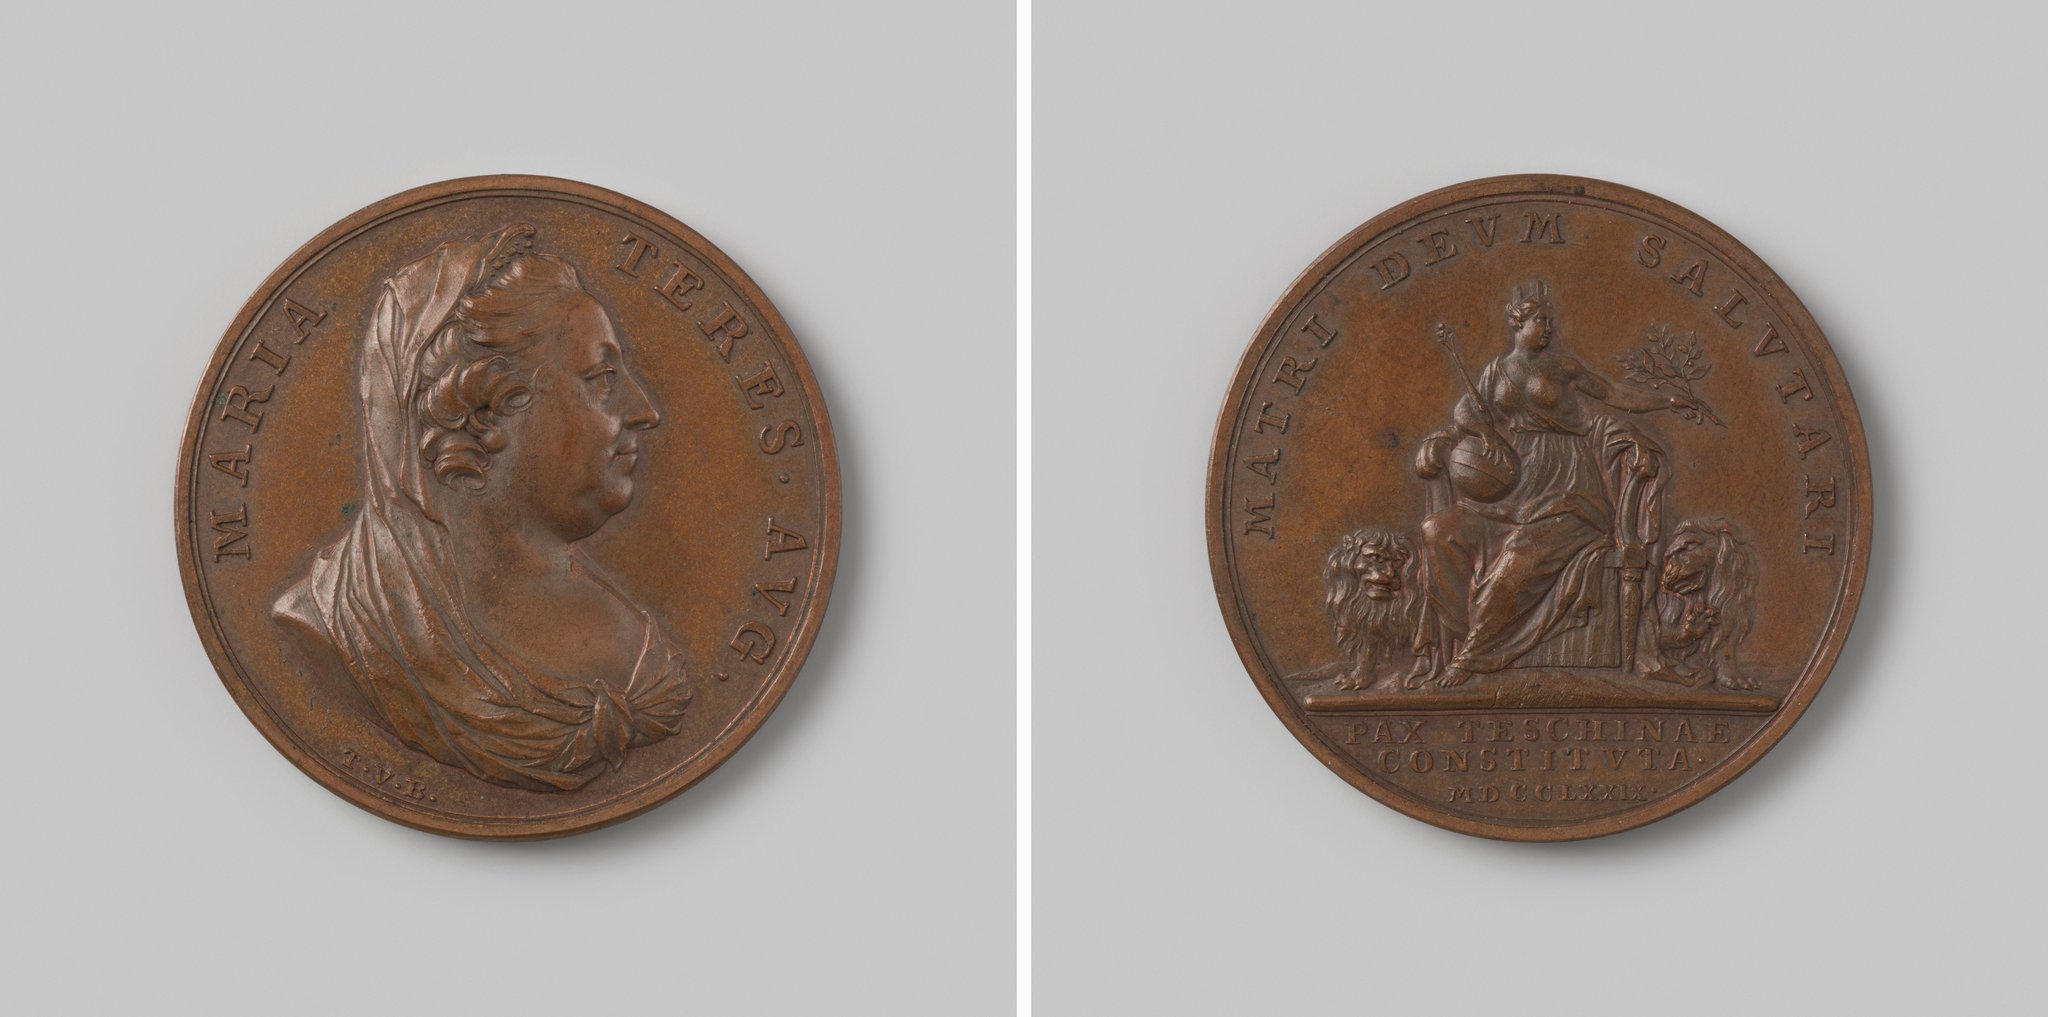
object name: history medal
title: Vrede van Tesschen 1779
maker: theodorus victor van berckel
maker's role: mintmaster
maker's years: 1739-1808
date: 1779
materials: copper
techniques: striking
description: Koperen penning, opde voorzijde het borstbeeld van Maria Theresia naar rechts met omschrift, op de keerzijde een vrouw met muurkroon, globe, scepter en olijftak op een troon tussen leeuwen, met omschrift en afsnedetekst.